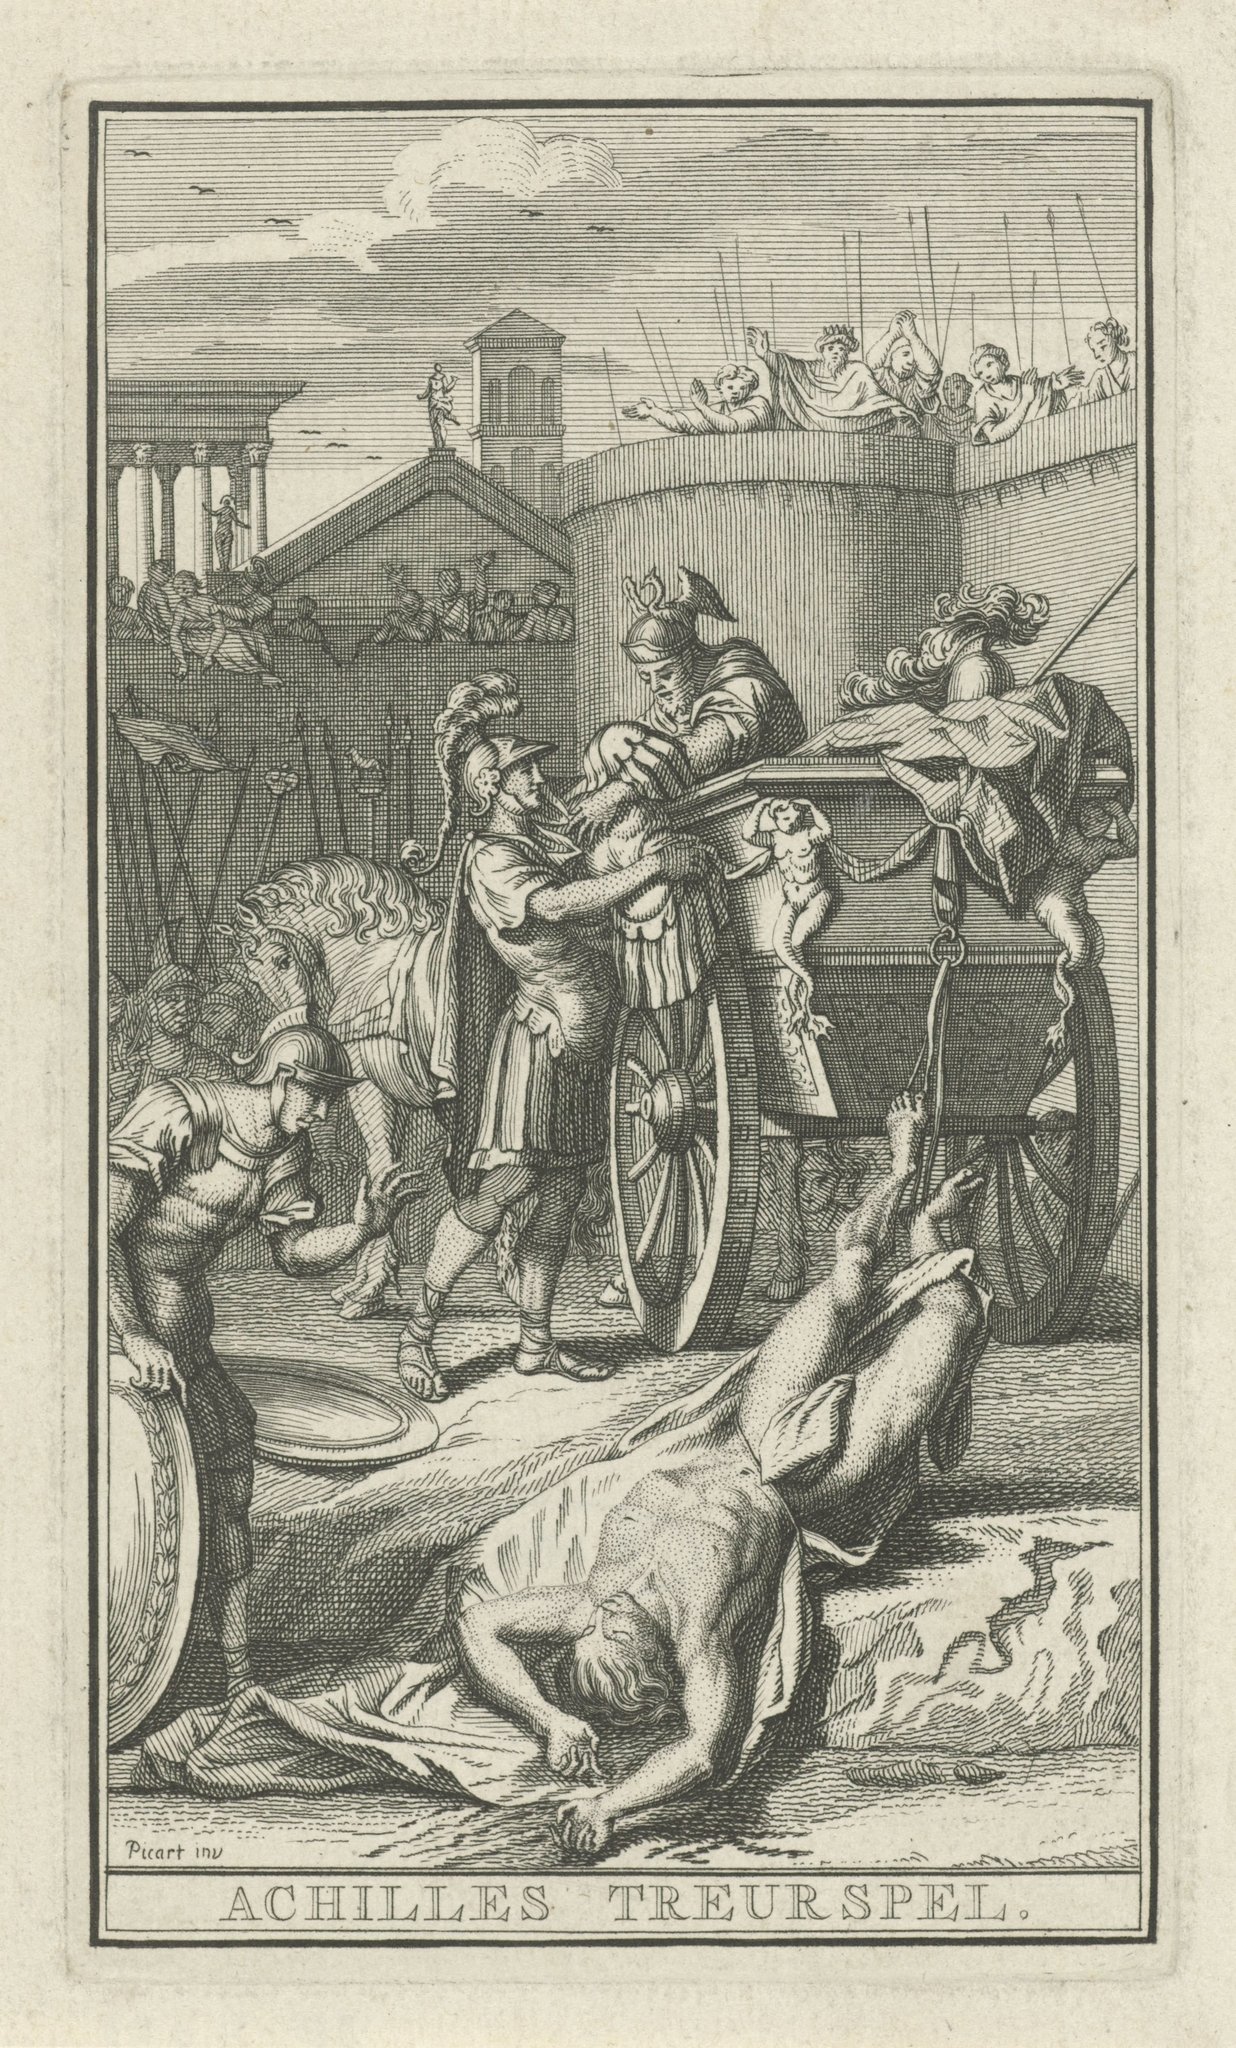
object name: print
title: Achilles met lijk van Hector achter zijn zegewagen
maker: bernard picart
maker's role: draughtsman, print maker, publisher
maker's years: 1673-1733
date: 1710-1760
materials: paper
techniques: engraving, etching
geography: amsterdam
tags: hector's body, tied to achilles' chariot, is dragged around the city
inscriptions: collector's mark: Lugt 2228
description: Achilles sleept het lichaam van Hector, dat aan zijn wagen is gebonden, langs de muren van Troje. Andromache kijkt toe vanaf de stadsmuur.